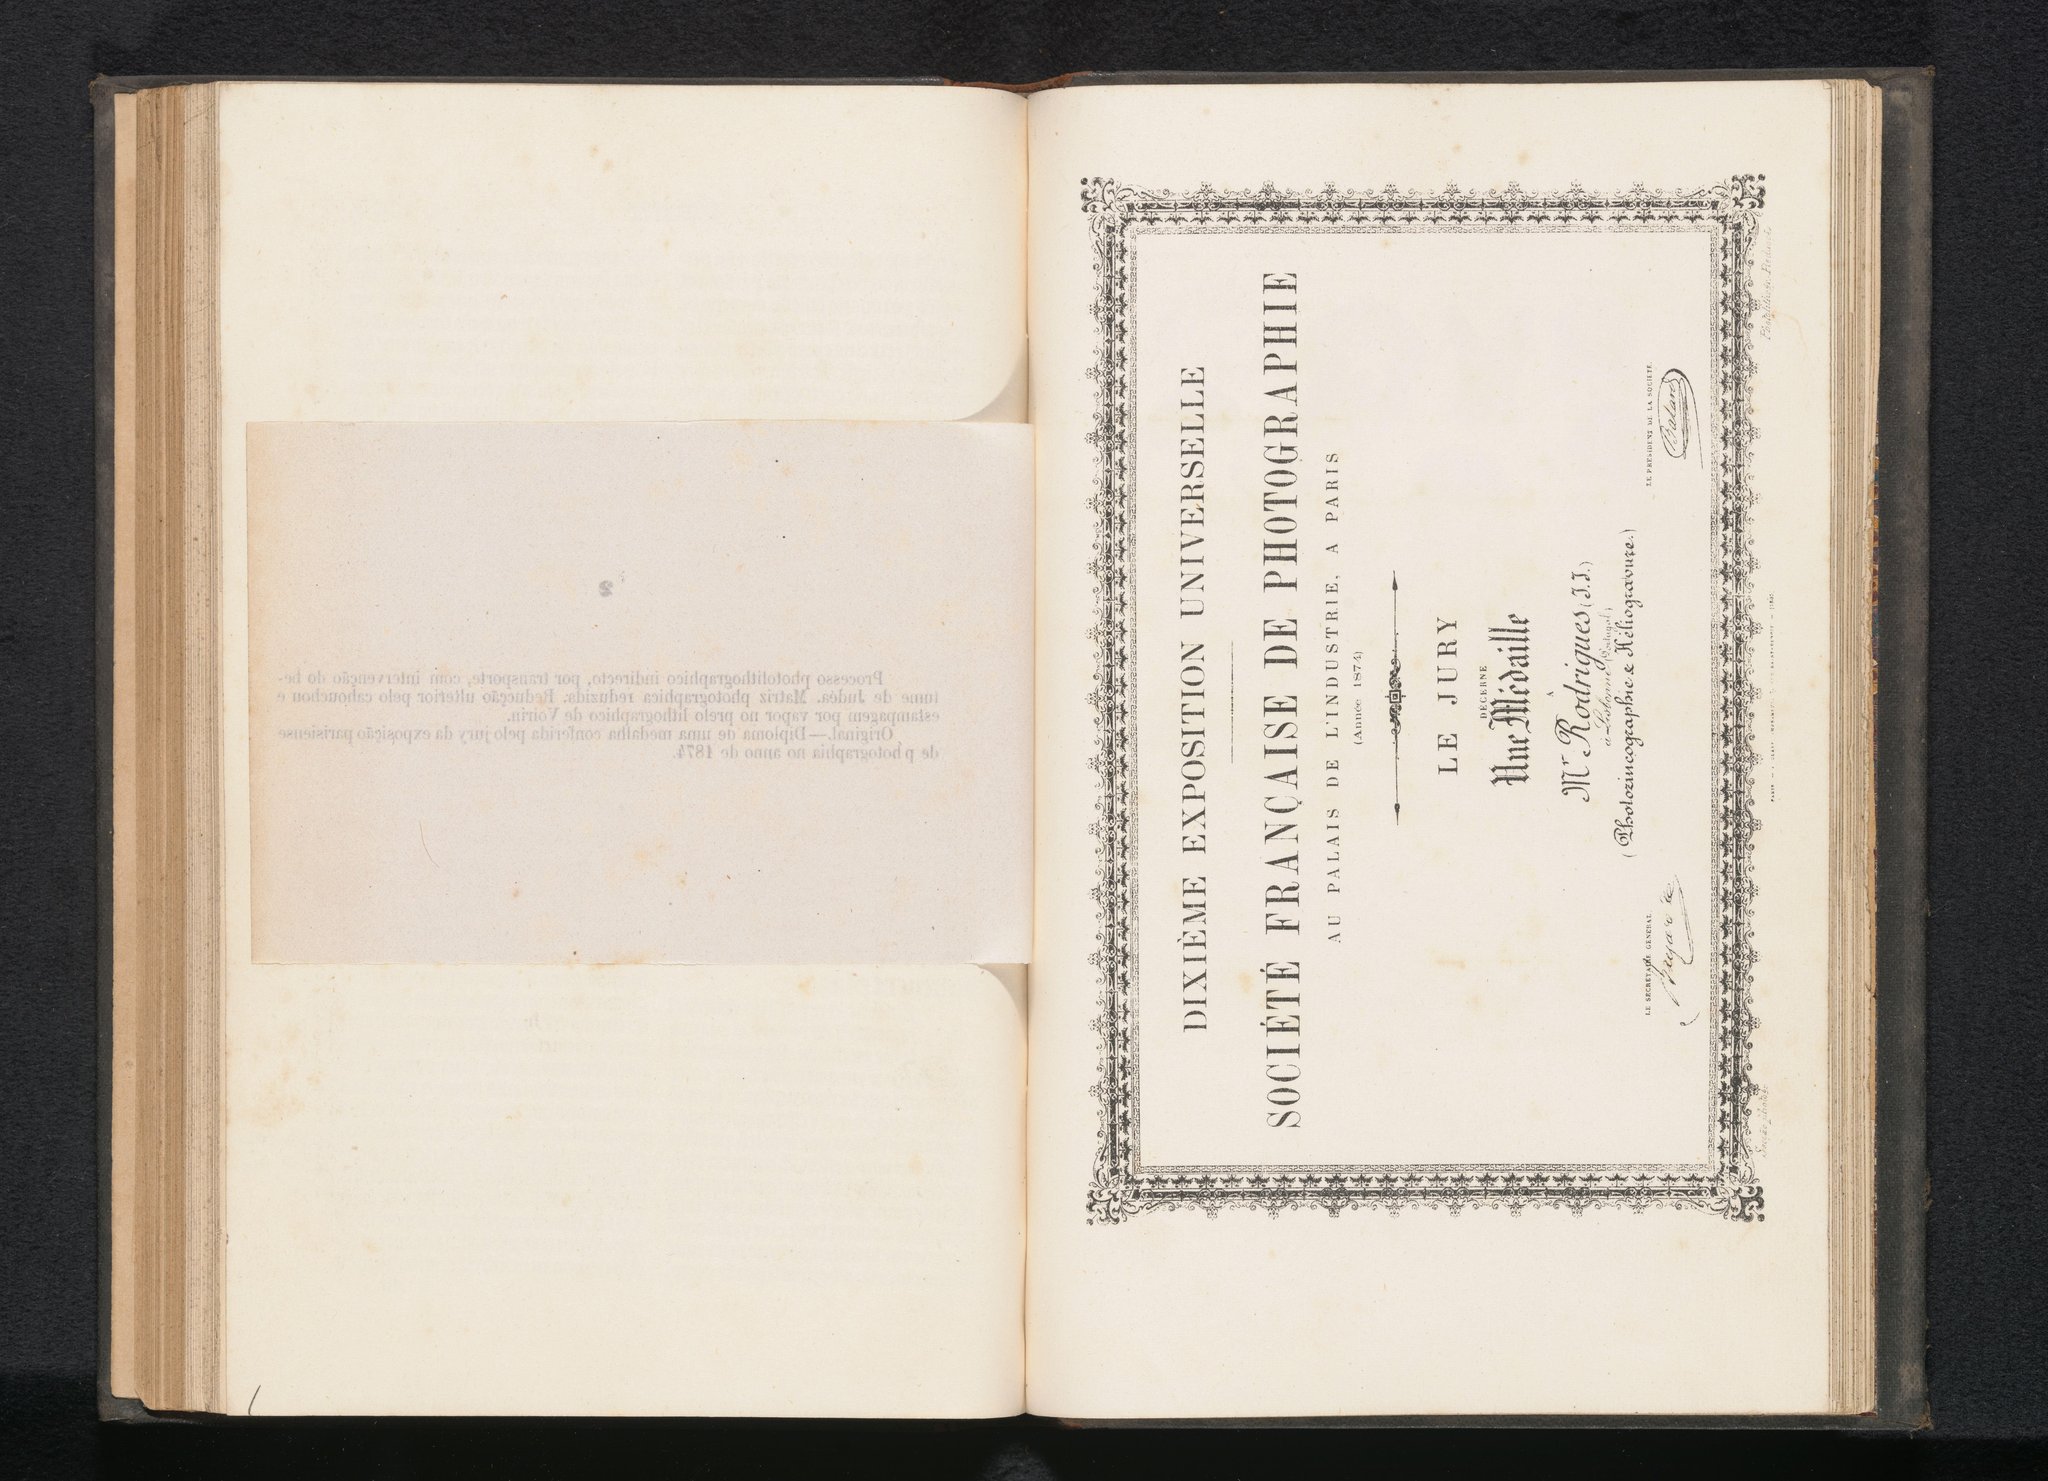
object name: reproduction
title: Fotoreproductie van een onderscheiding van de Société Française de Photographie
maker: Anonymous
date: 1874-1876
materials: paper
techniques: photolithography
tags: distribution of awards ~ art contest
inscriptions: number: ‘2’